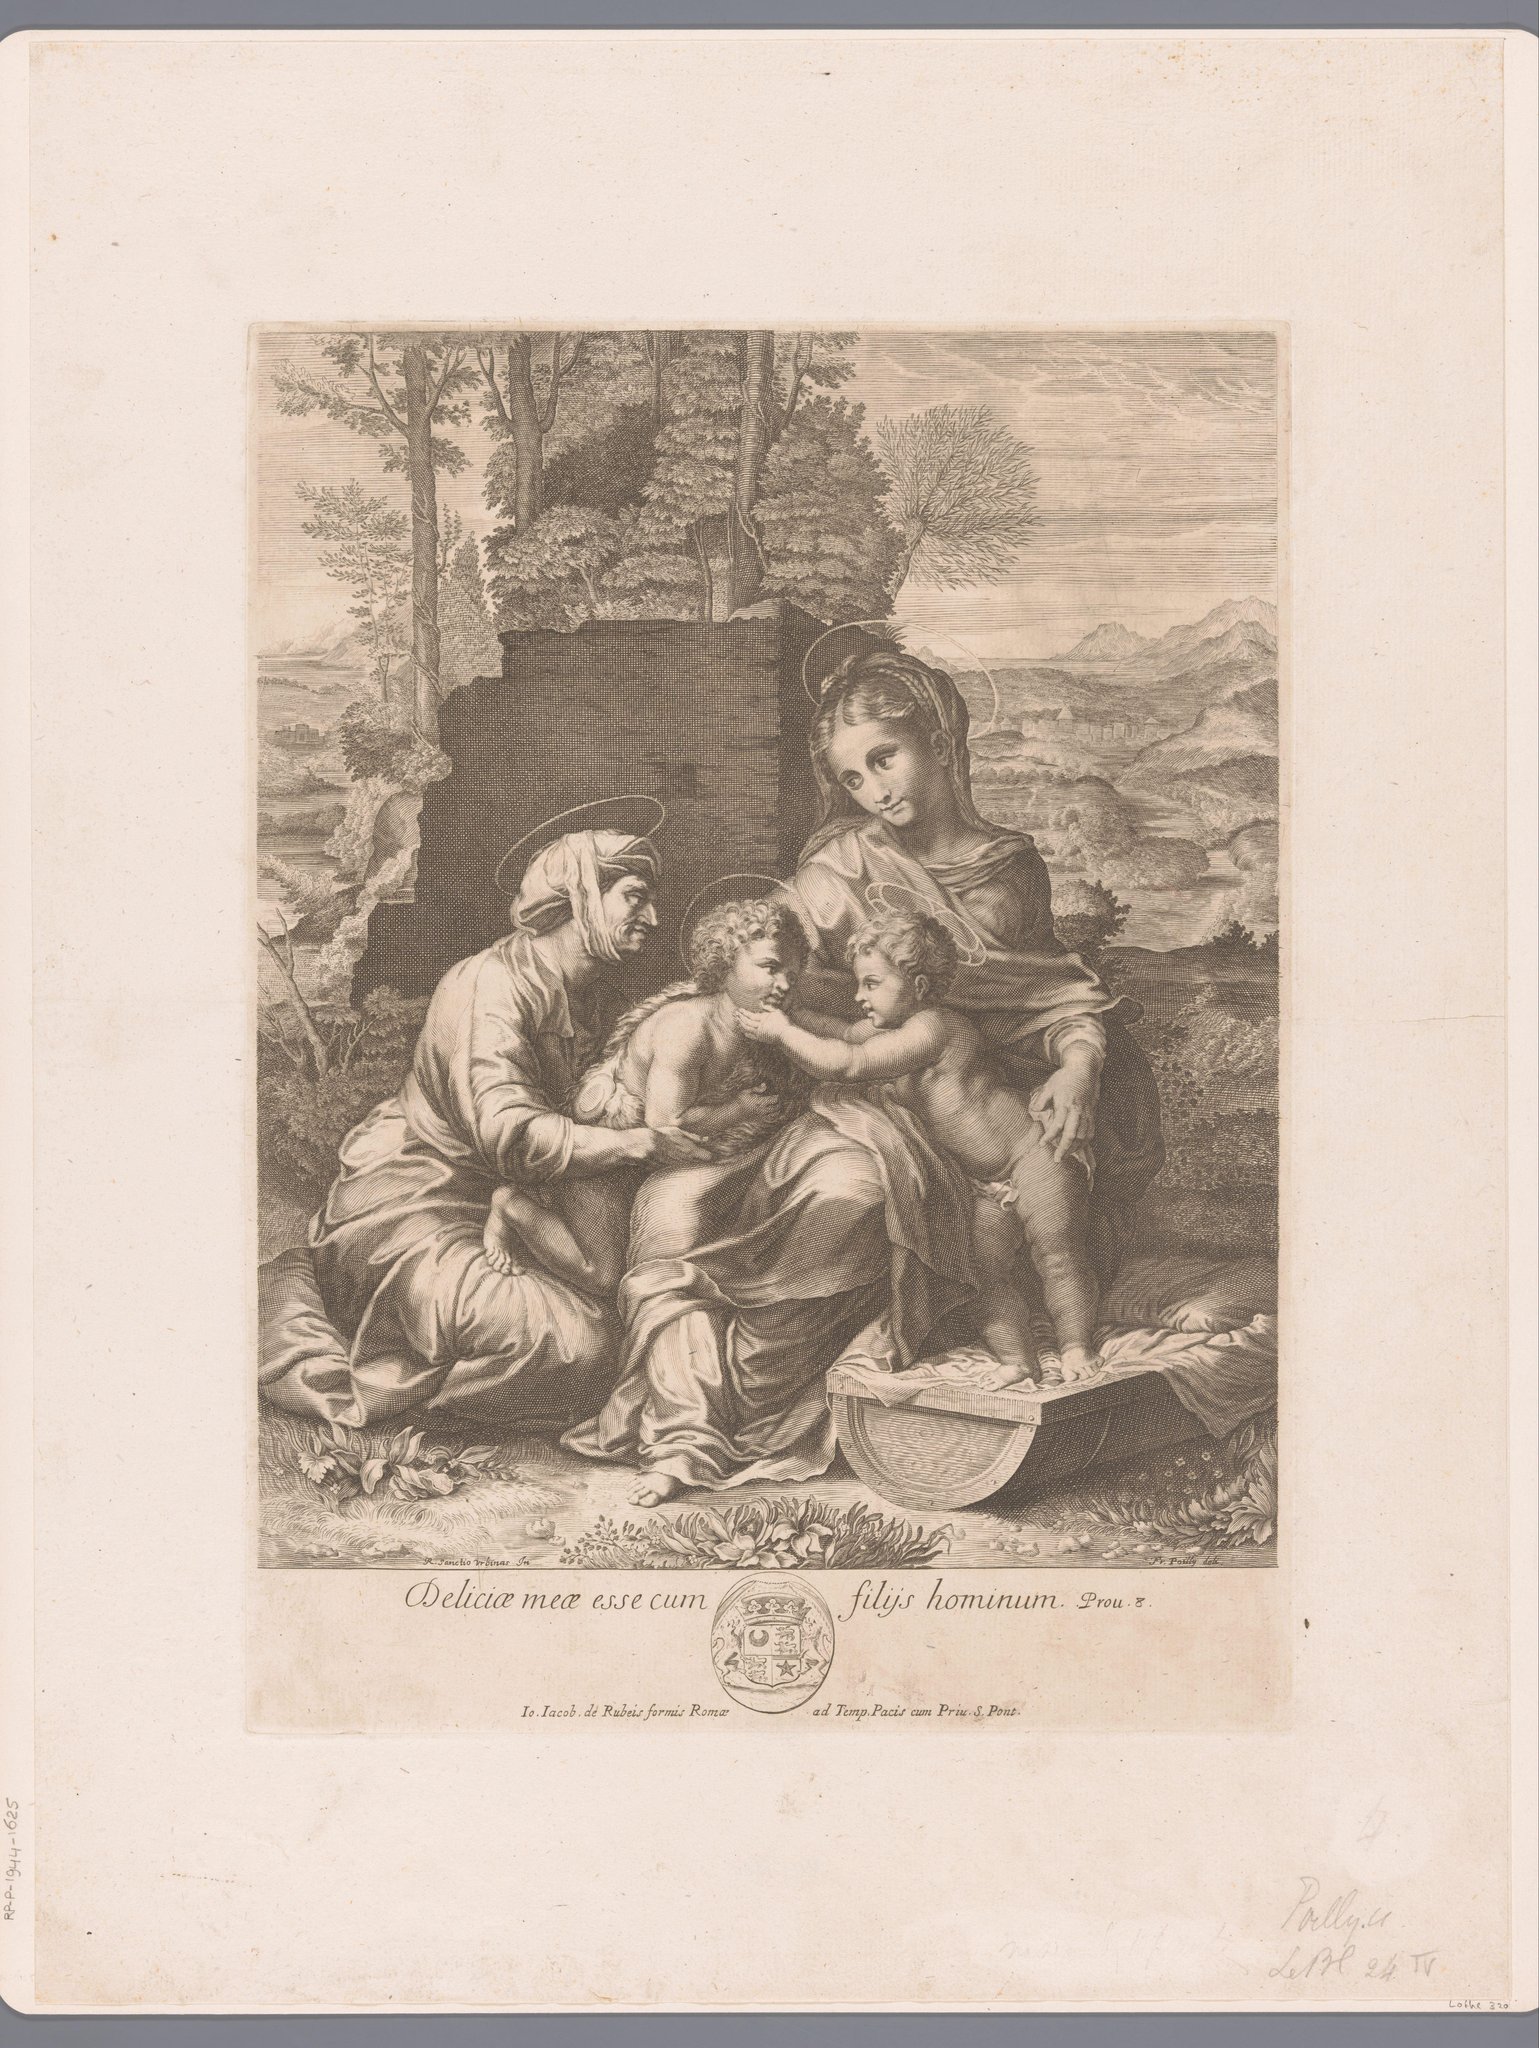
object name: print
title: Maria met kind staand in kribbe, en Elisabet met Johannes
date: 1632-1693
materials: paper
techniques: engraving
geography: rome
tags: mary, the christ-child and john the baptist, elisabeth present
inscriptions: collector's mark: Lugt 2228